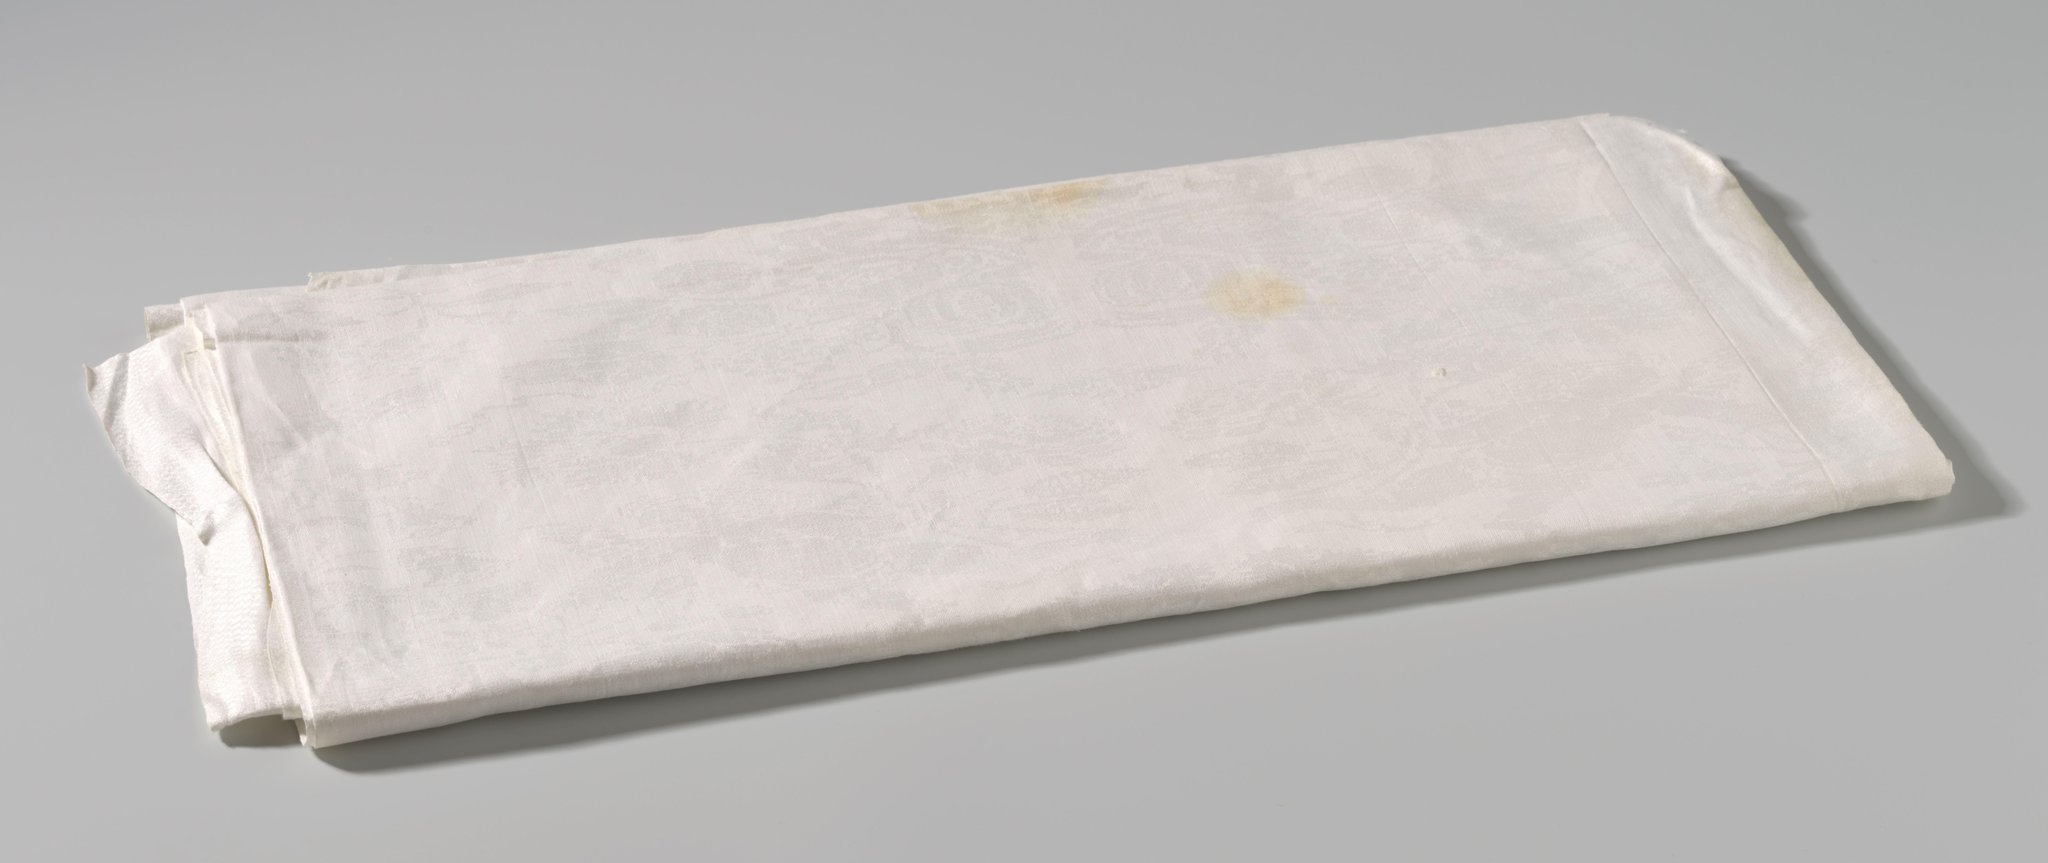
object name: tablecloth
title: Tafellaken van linnendamast met putti en bloemen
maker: Anonymous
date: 1660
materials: linen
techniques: damask, weave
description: Tafellaken van linnendamast. Het patroon heeft bloemen en vruchten waartussen putti die hoorns des overvloed dragen en putti die een bloemenmand dragen. De dubbele lopende randen hebben een slingerende bloemenrank met vruchten en vogels. Bij het tafellaken hoort een servet (BK-KOG-2607-B).